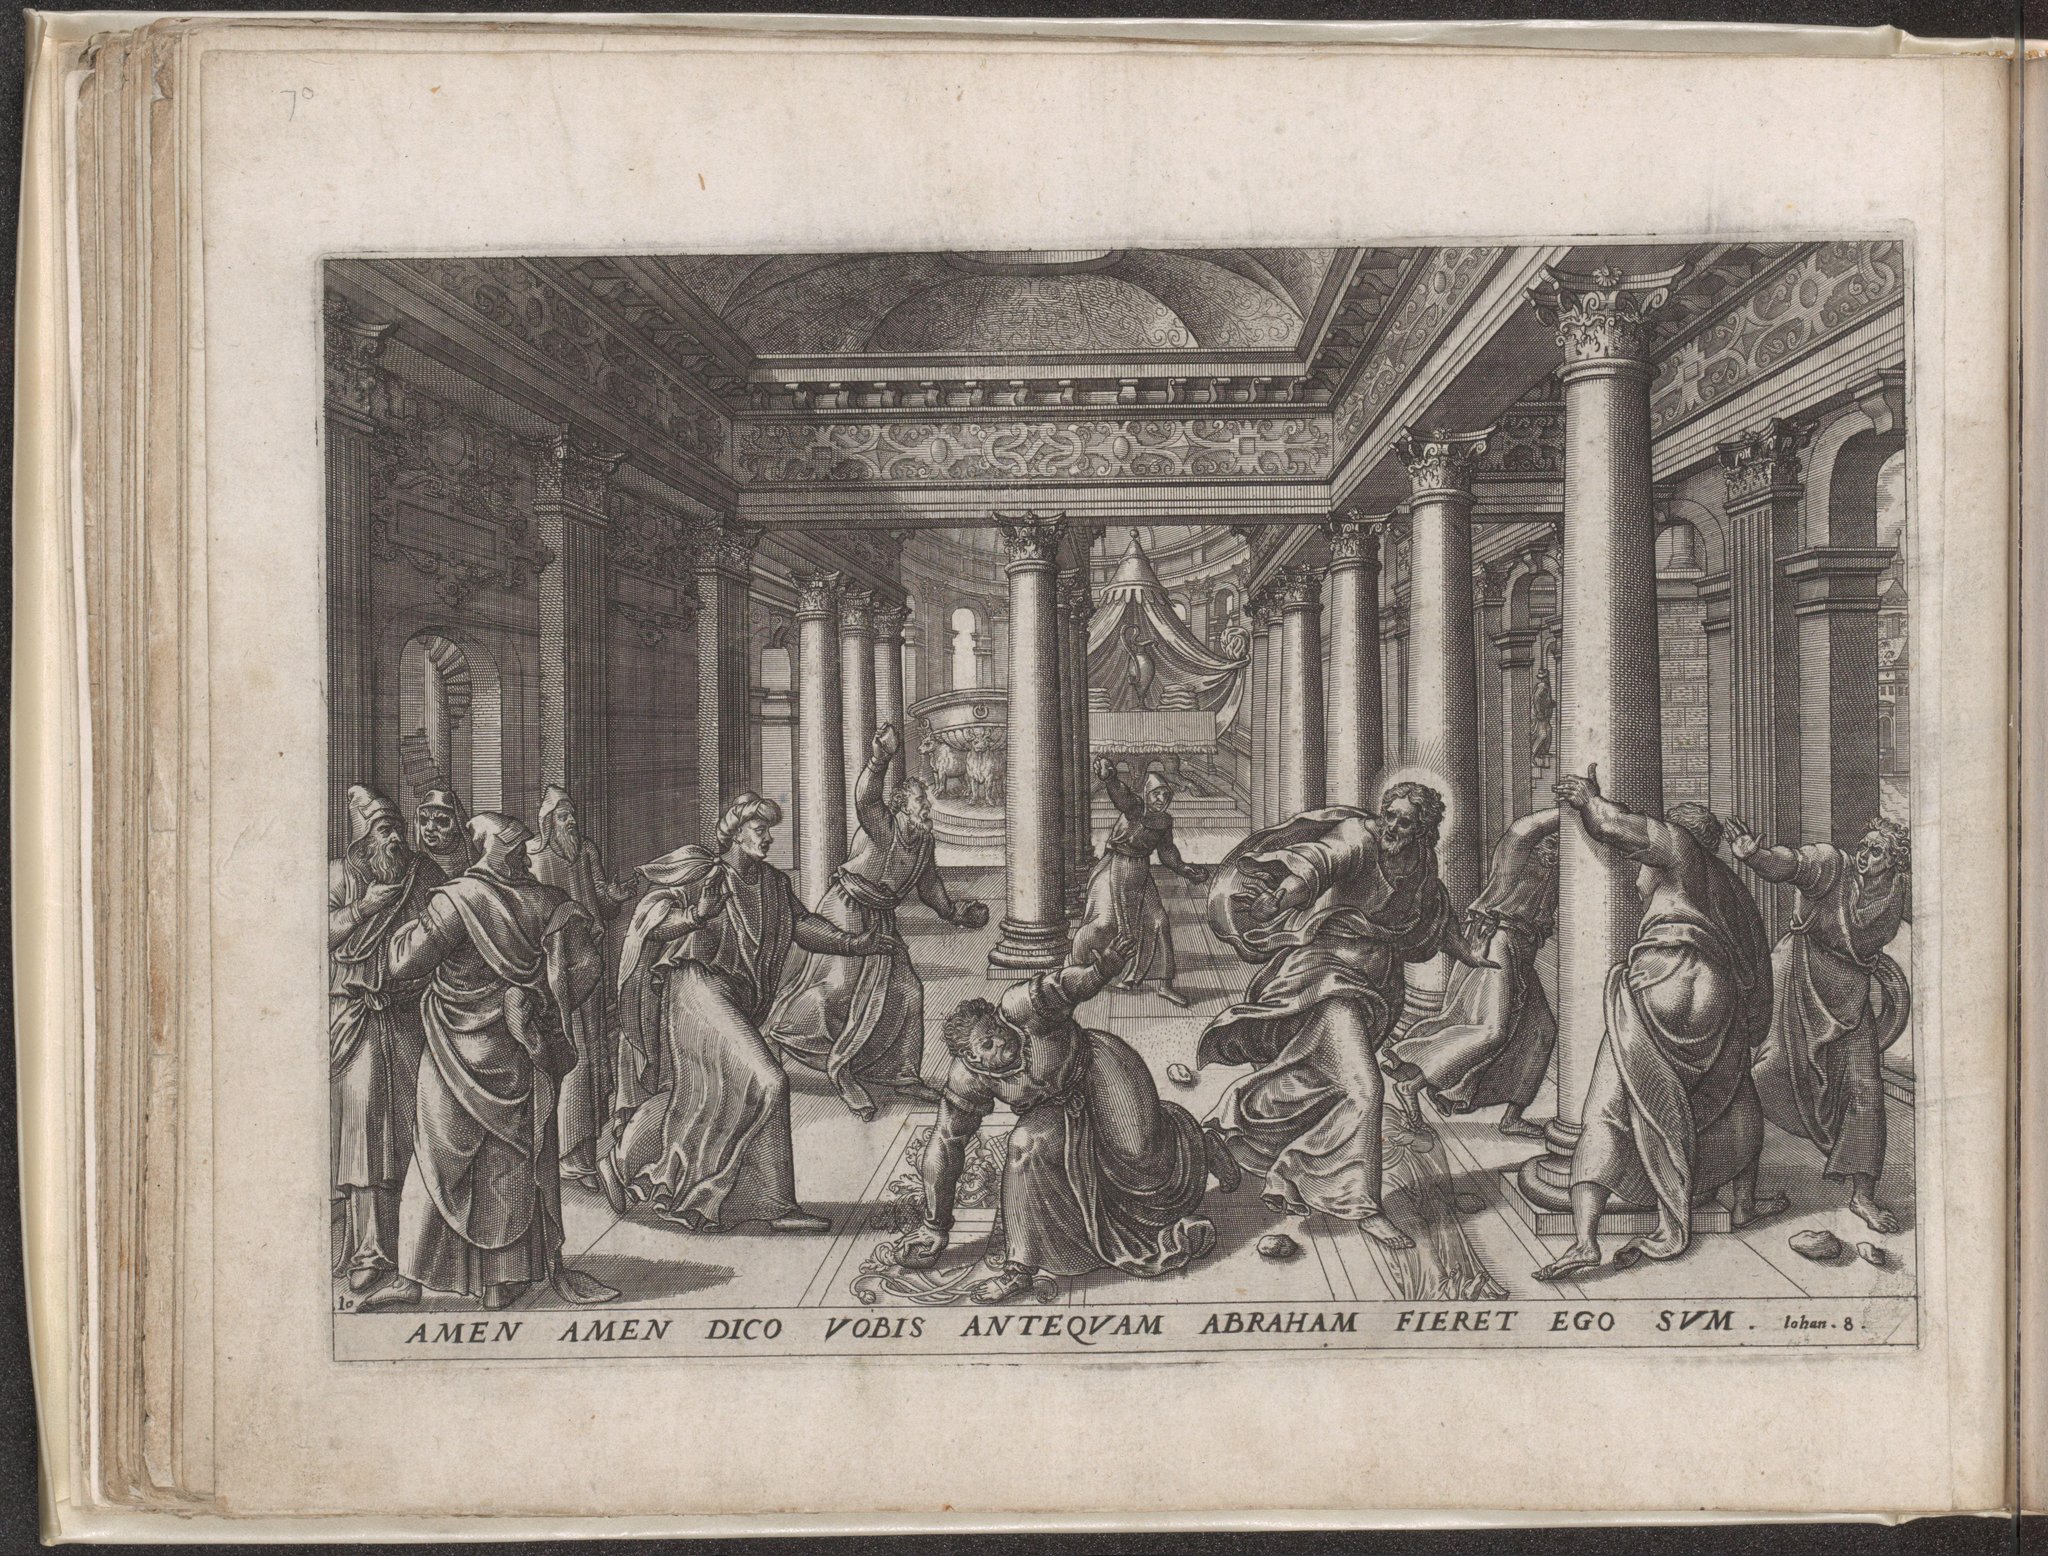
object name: album leaf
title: Gebeurtenissen in en rond de tempel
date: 1570-1574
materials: paper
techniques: engraving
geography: antwerp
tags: attempts to stone christ (john 8:59, 10:31-33)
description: In de tempel rapen Joodse mannen stenen op om naar Christus te gooien, nadat Christus de uitspraak heeft gedaan dat hij er al voor Abraham was. Christus vlucht weg. Onder de voorstelling een verwijzing in het Latijn naar de Bijbeltekst in Joh. 8. Deze prent maakt deel uit van een album.